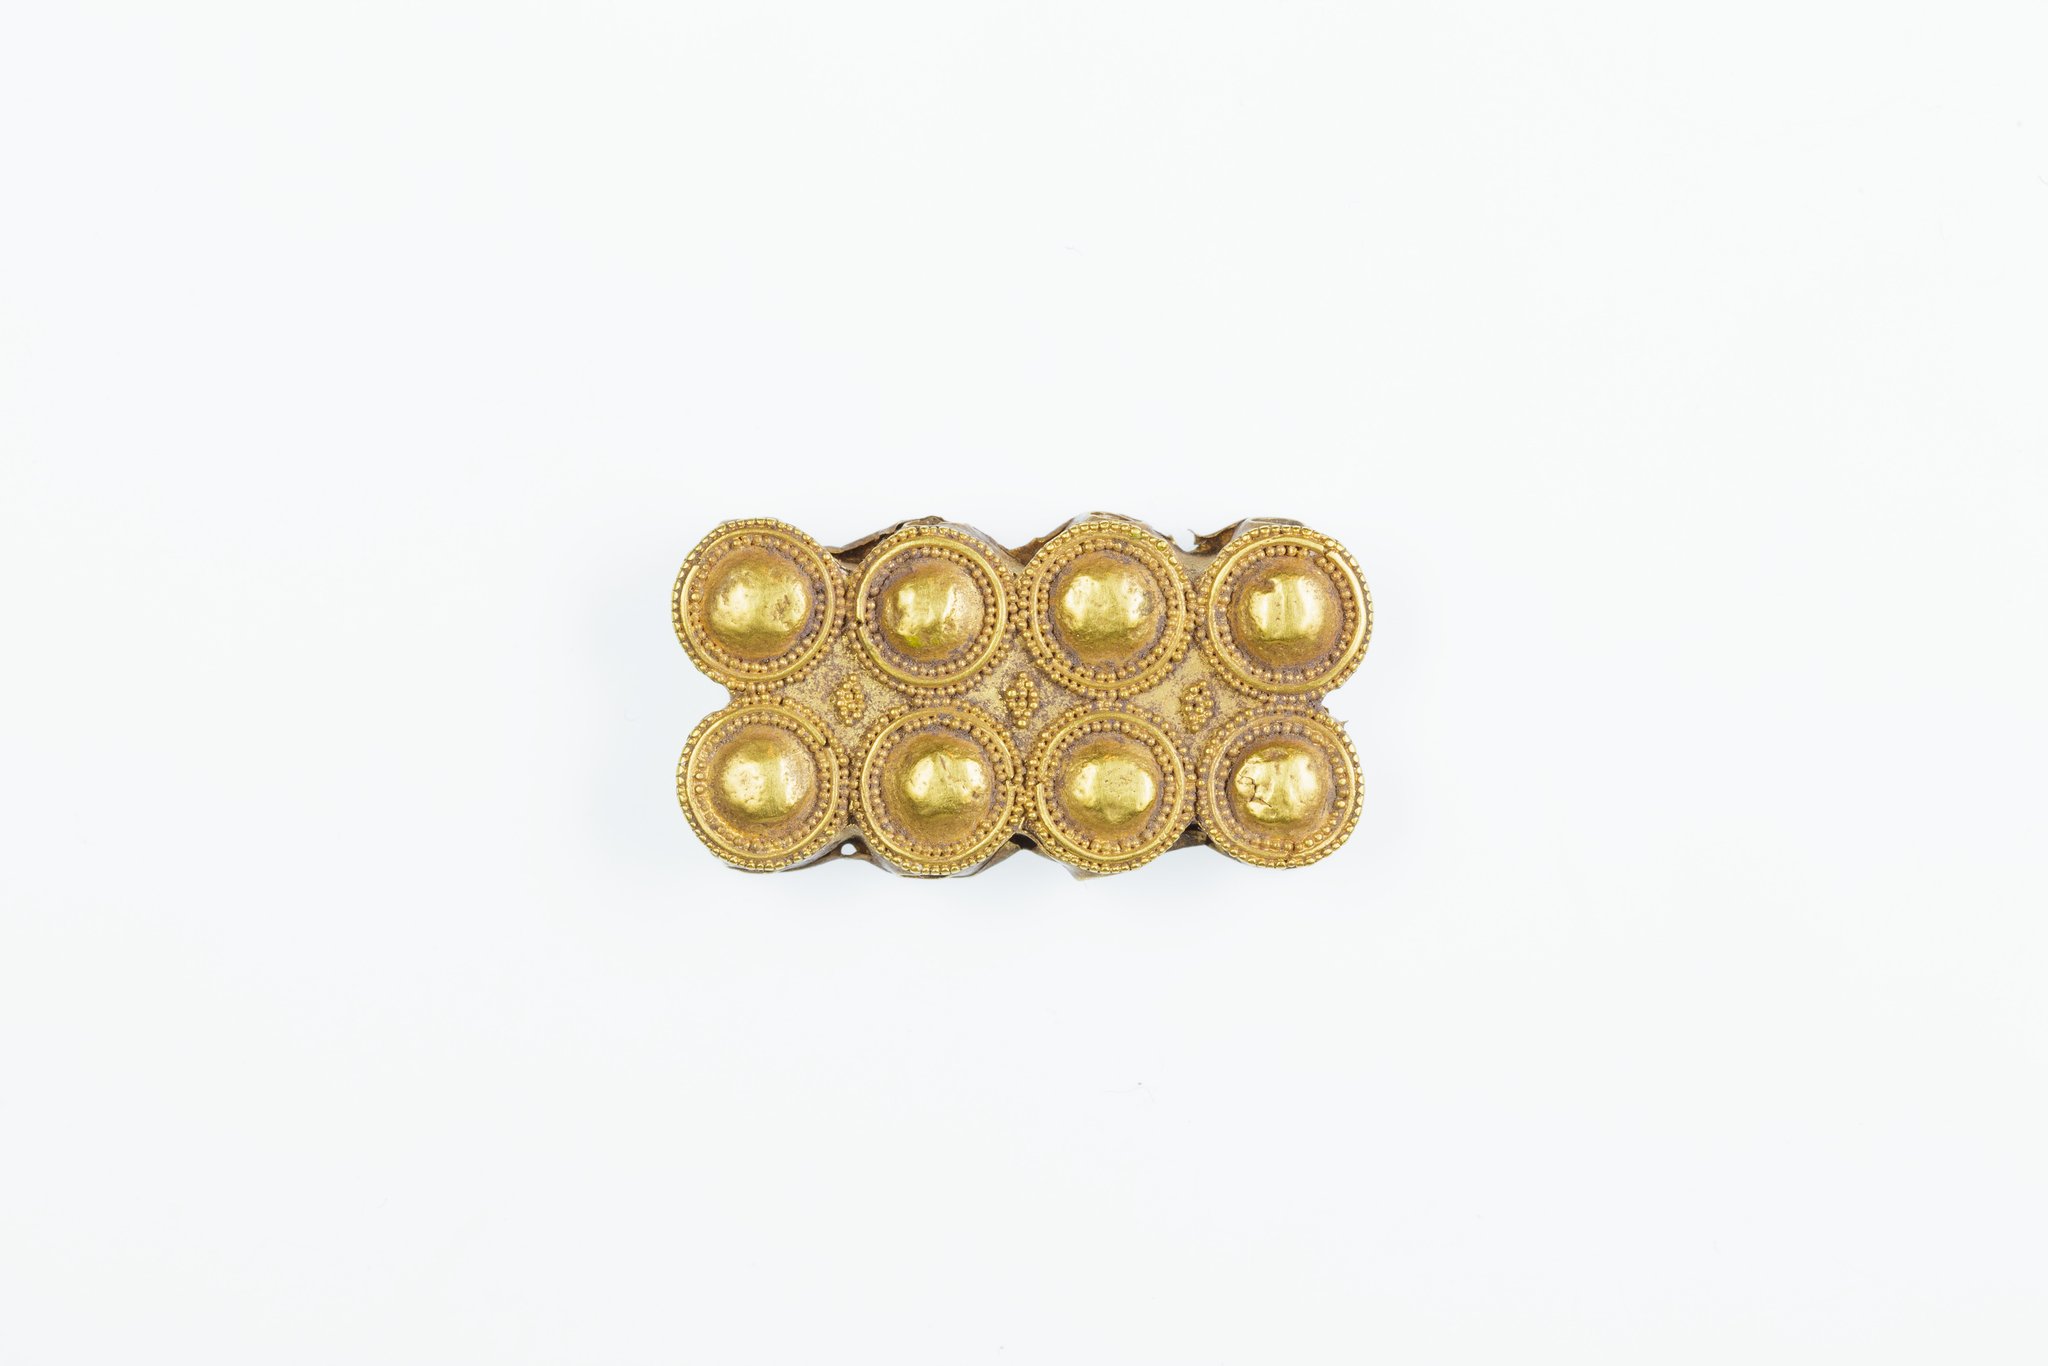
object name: broad collar spacer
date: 304-30 BCE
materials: gold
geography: egypt